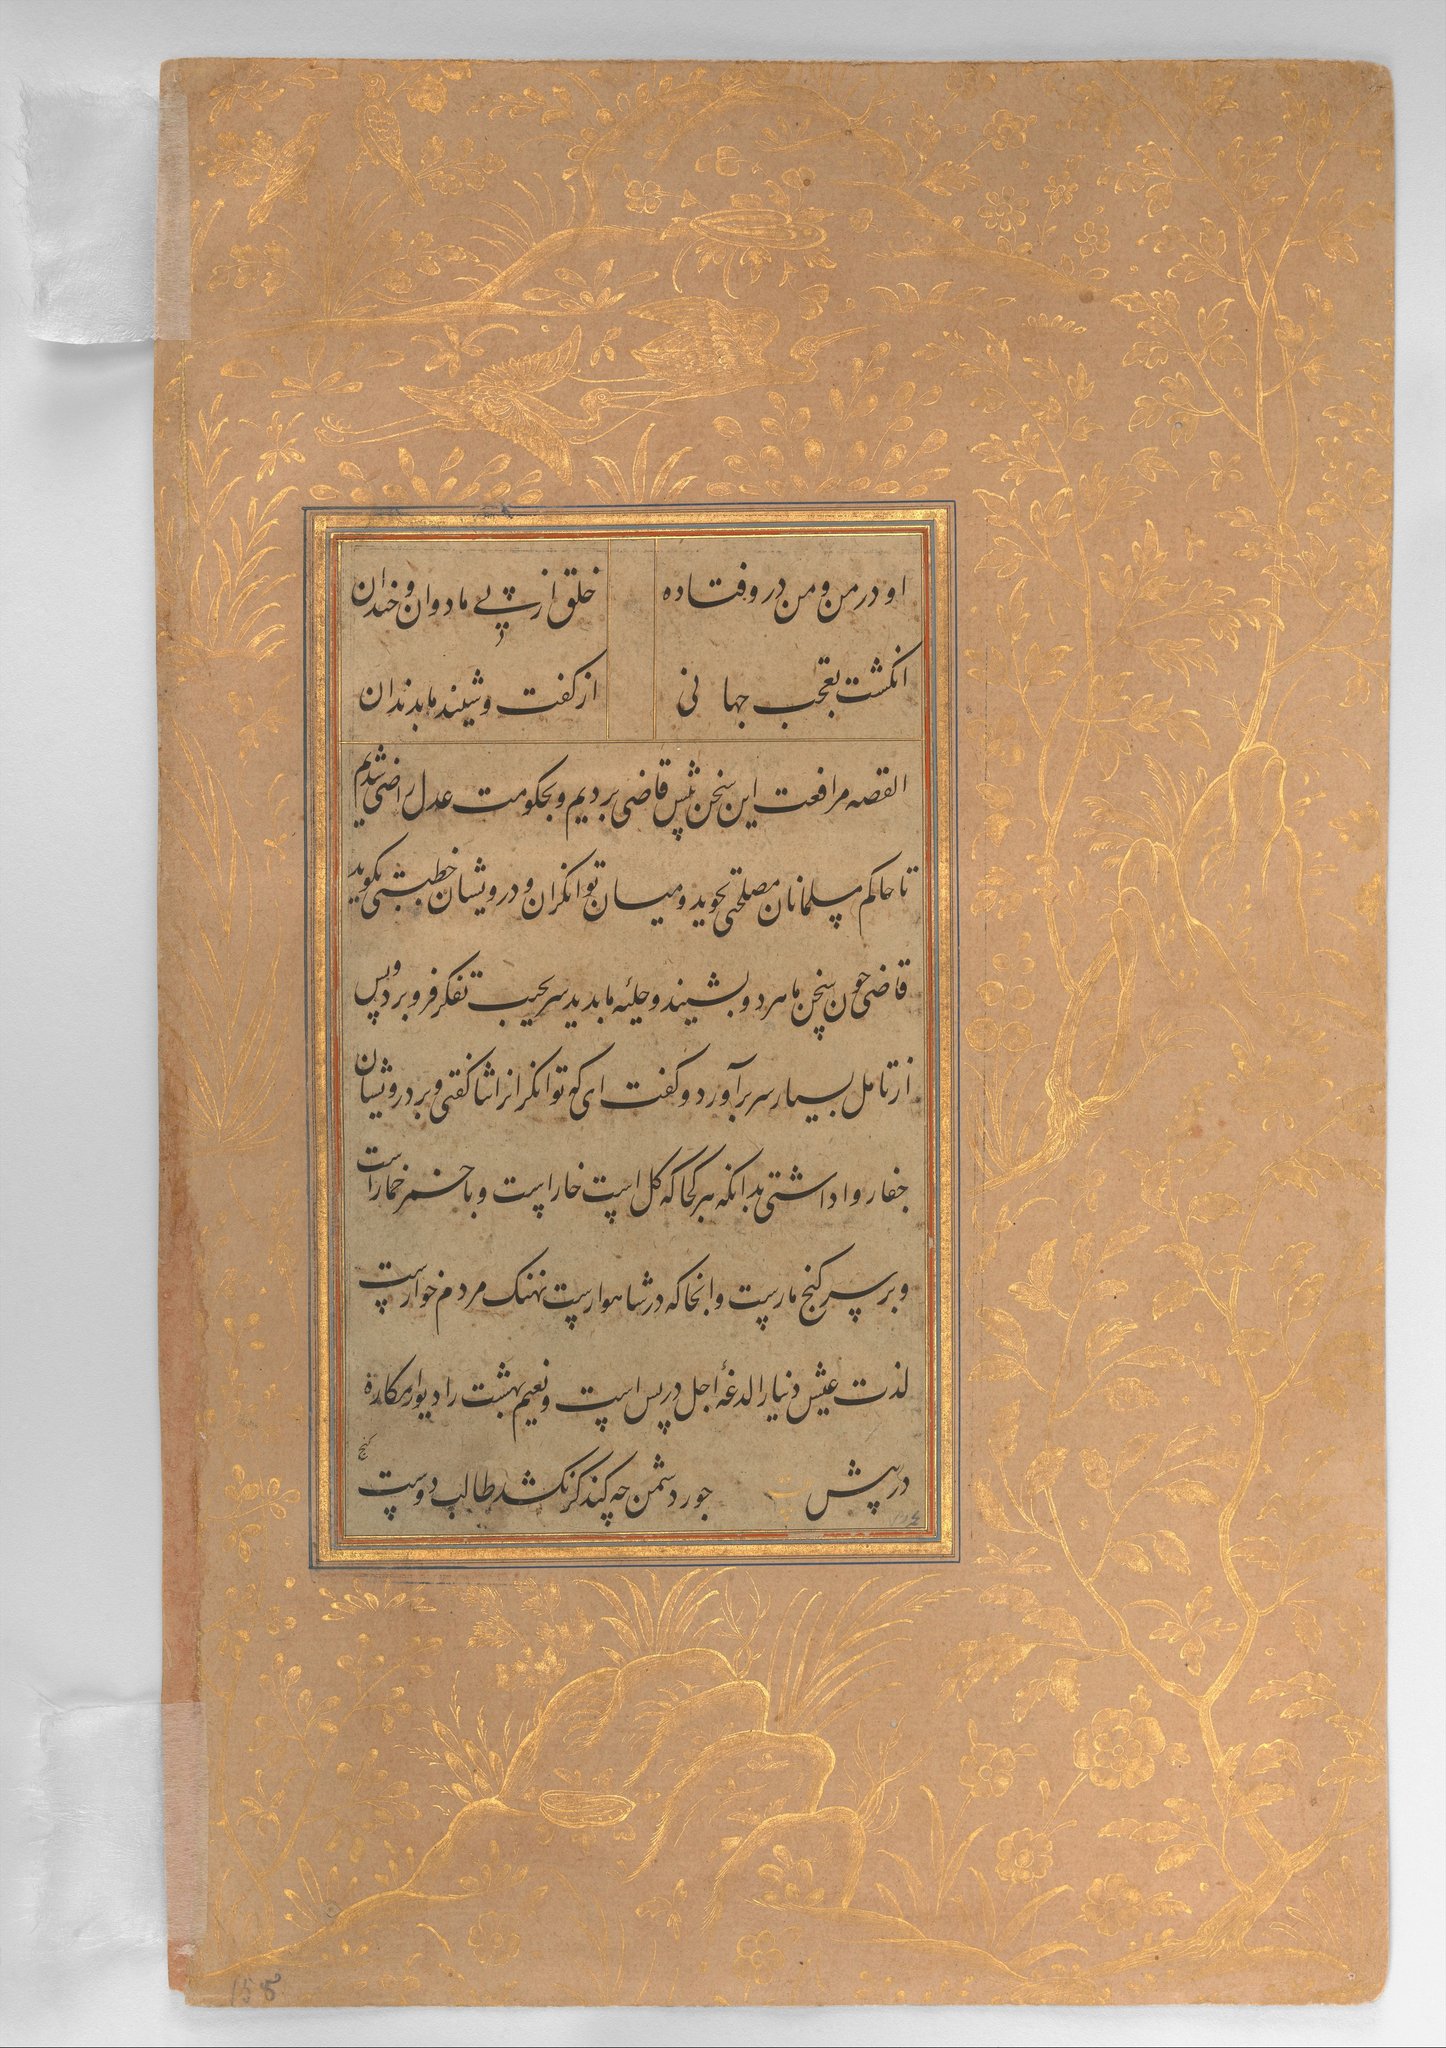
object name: folio from a non illustrated manuscript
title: Page of Calligraphy from an Anthology of Poetry by Sa`di and Hafiz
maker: sa'di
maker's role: author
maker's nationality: iranian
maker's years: 1213-1291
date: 1467-1500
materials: gold, ink, paper, silver, watercolor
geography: afghanistan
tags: poetry,calligraphy